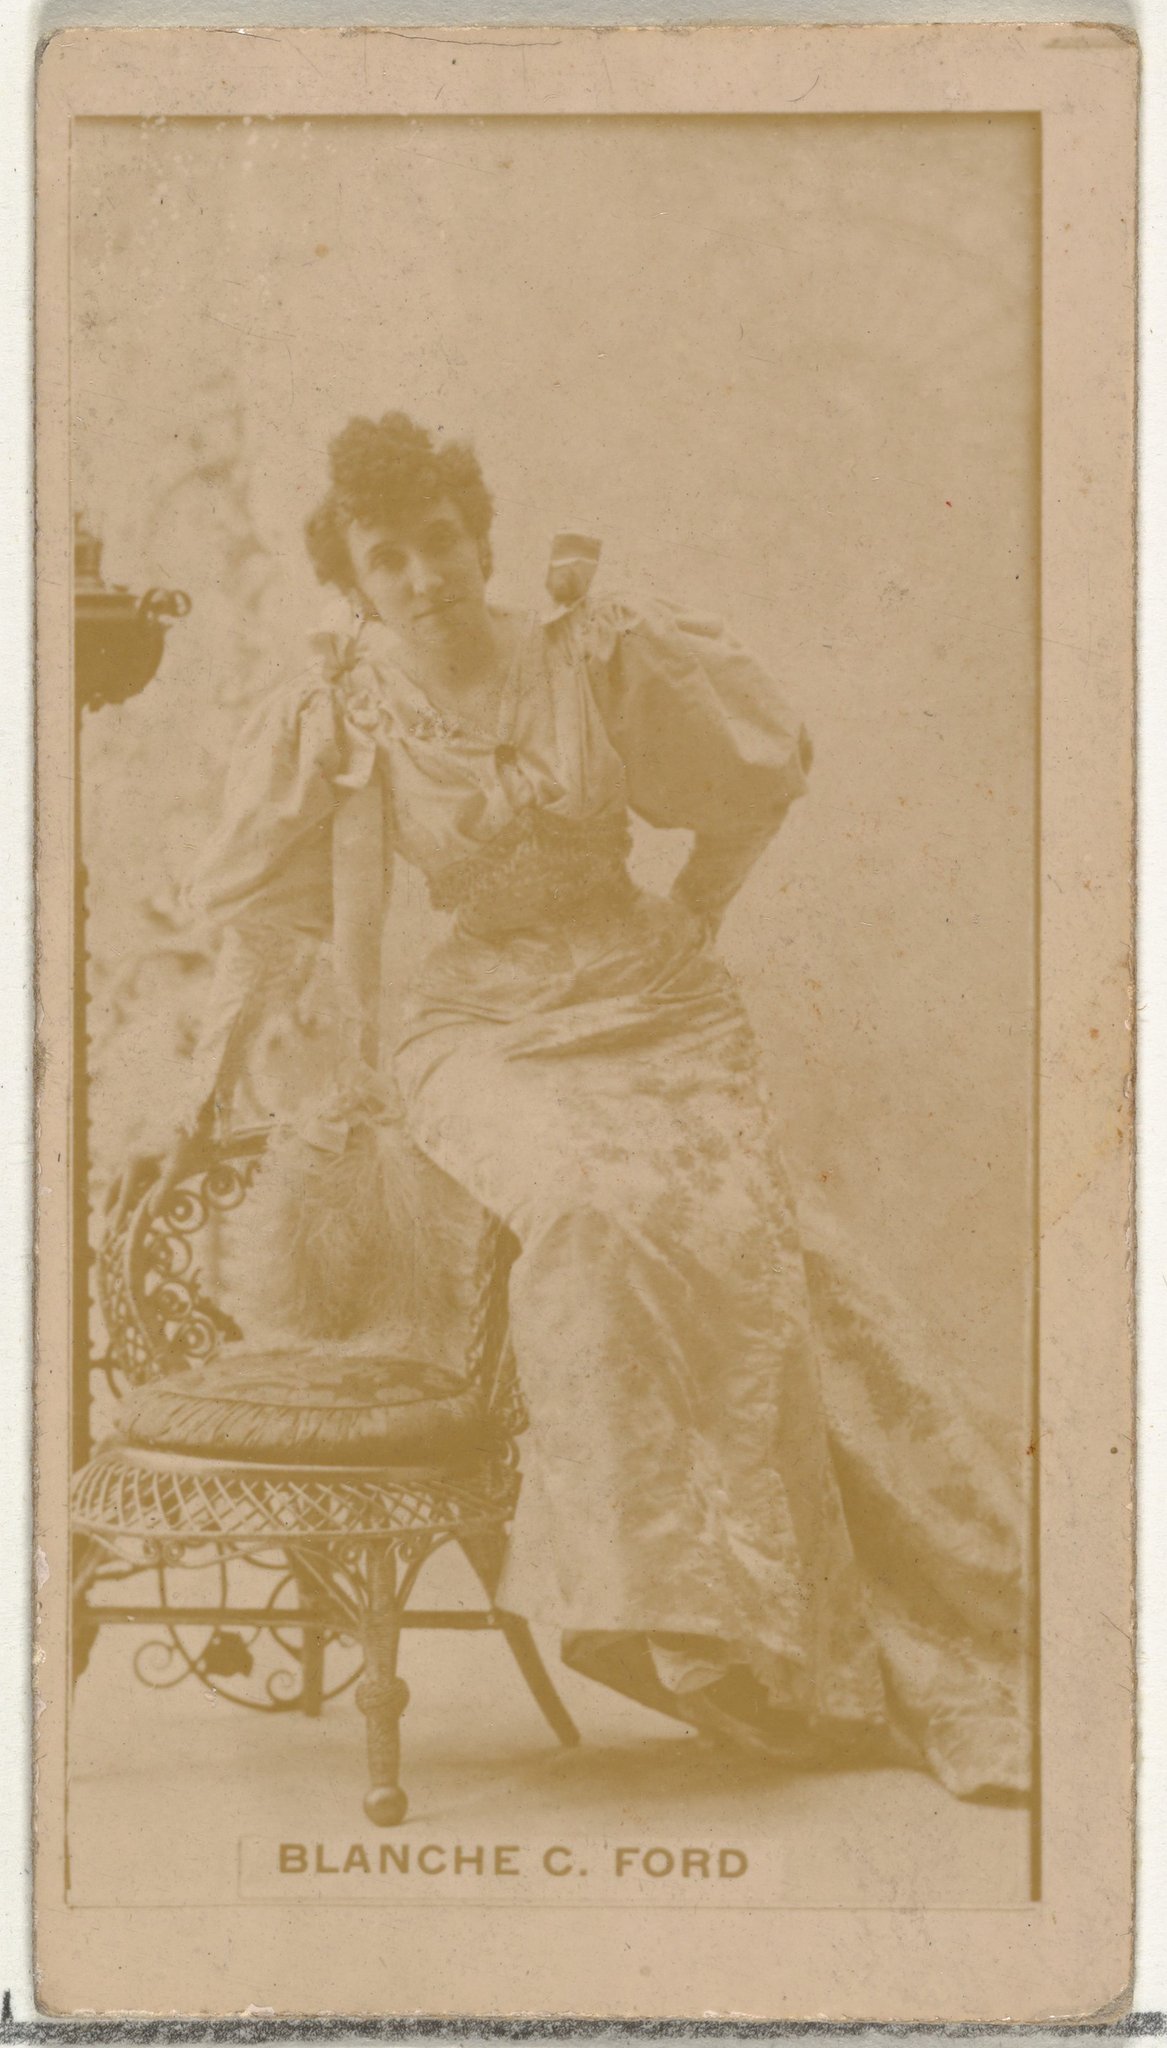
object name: photograph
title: Blanche C. Ford, from the Actors and Actresses series (N145-8) issued by Duke Sons & Co. to promote Duke Cigarettes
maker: w. duke, sons & co.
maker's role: publisher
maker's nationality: american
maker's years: 1870-1920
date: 1891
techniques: albumen silver print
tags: portraits,women,actresses